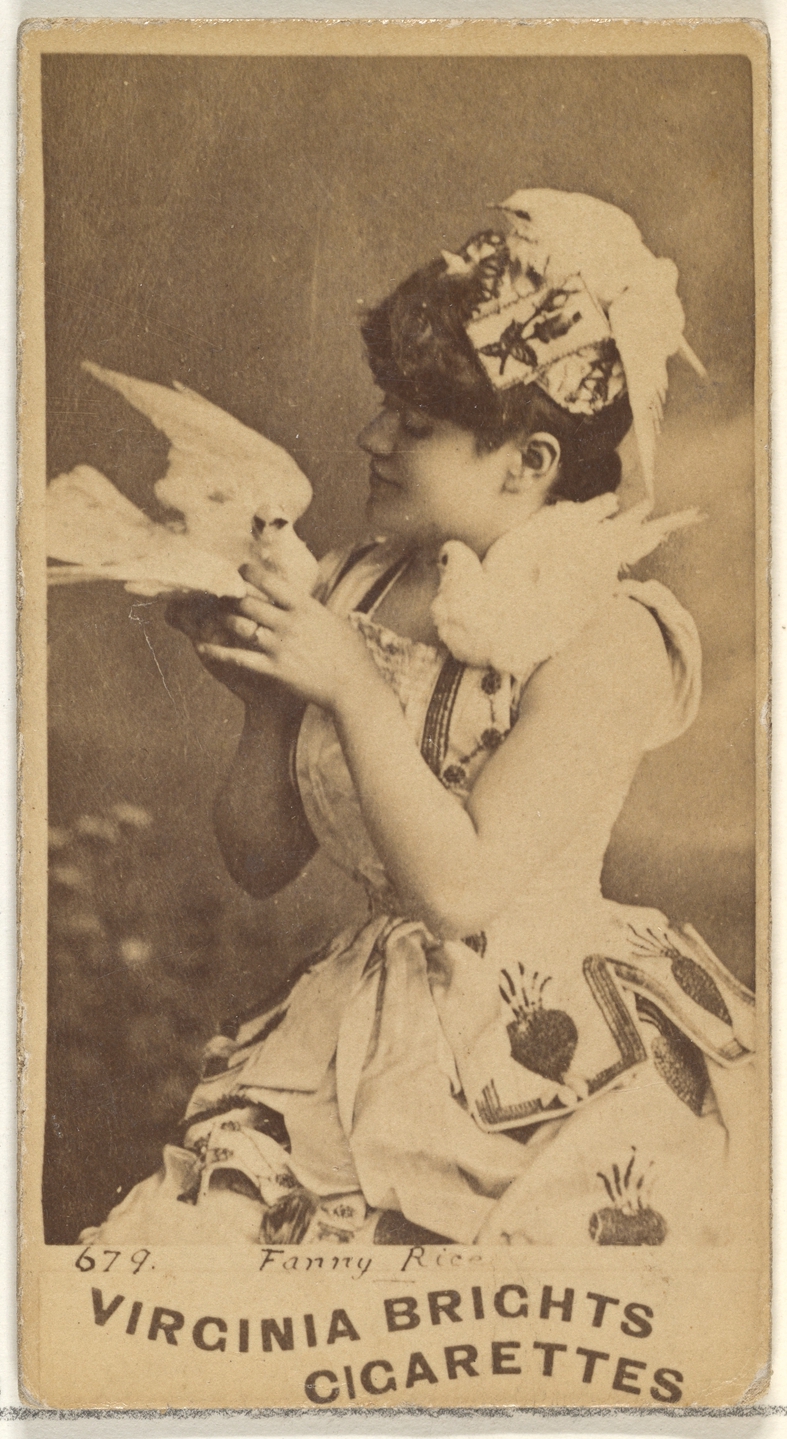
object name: photograph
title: Card 679, Fanny Rice, from the Actors and Actresses series (N45, Type 1) for Virginia Brights Cigarettes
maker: allen & ginter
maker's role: publisher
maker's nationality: american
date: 1888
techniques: albumen silver print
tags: birds,women,actresses